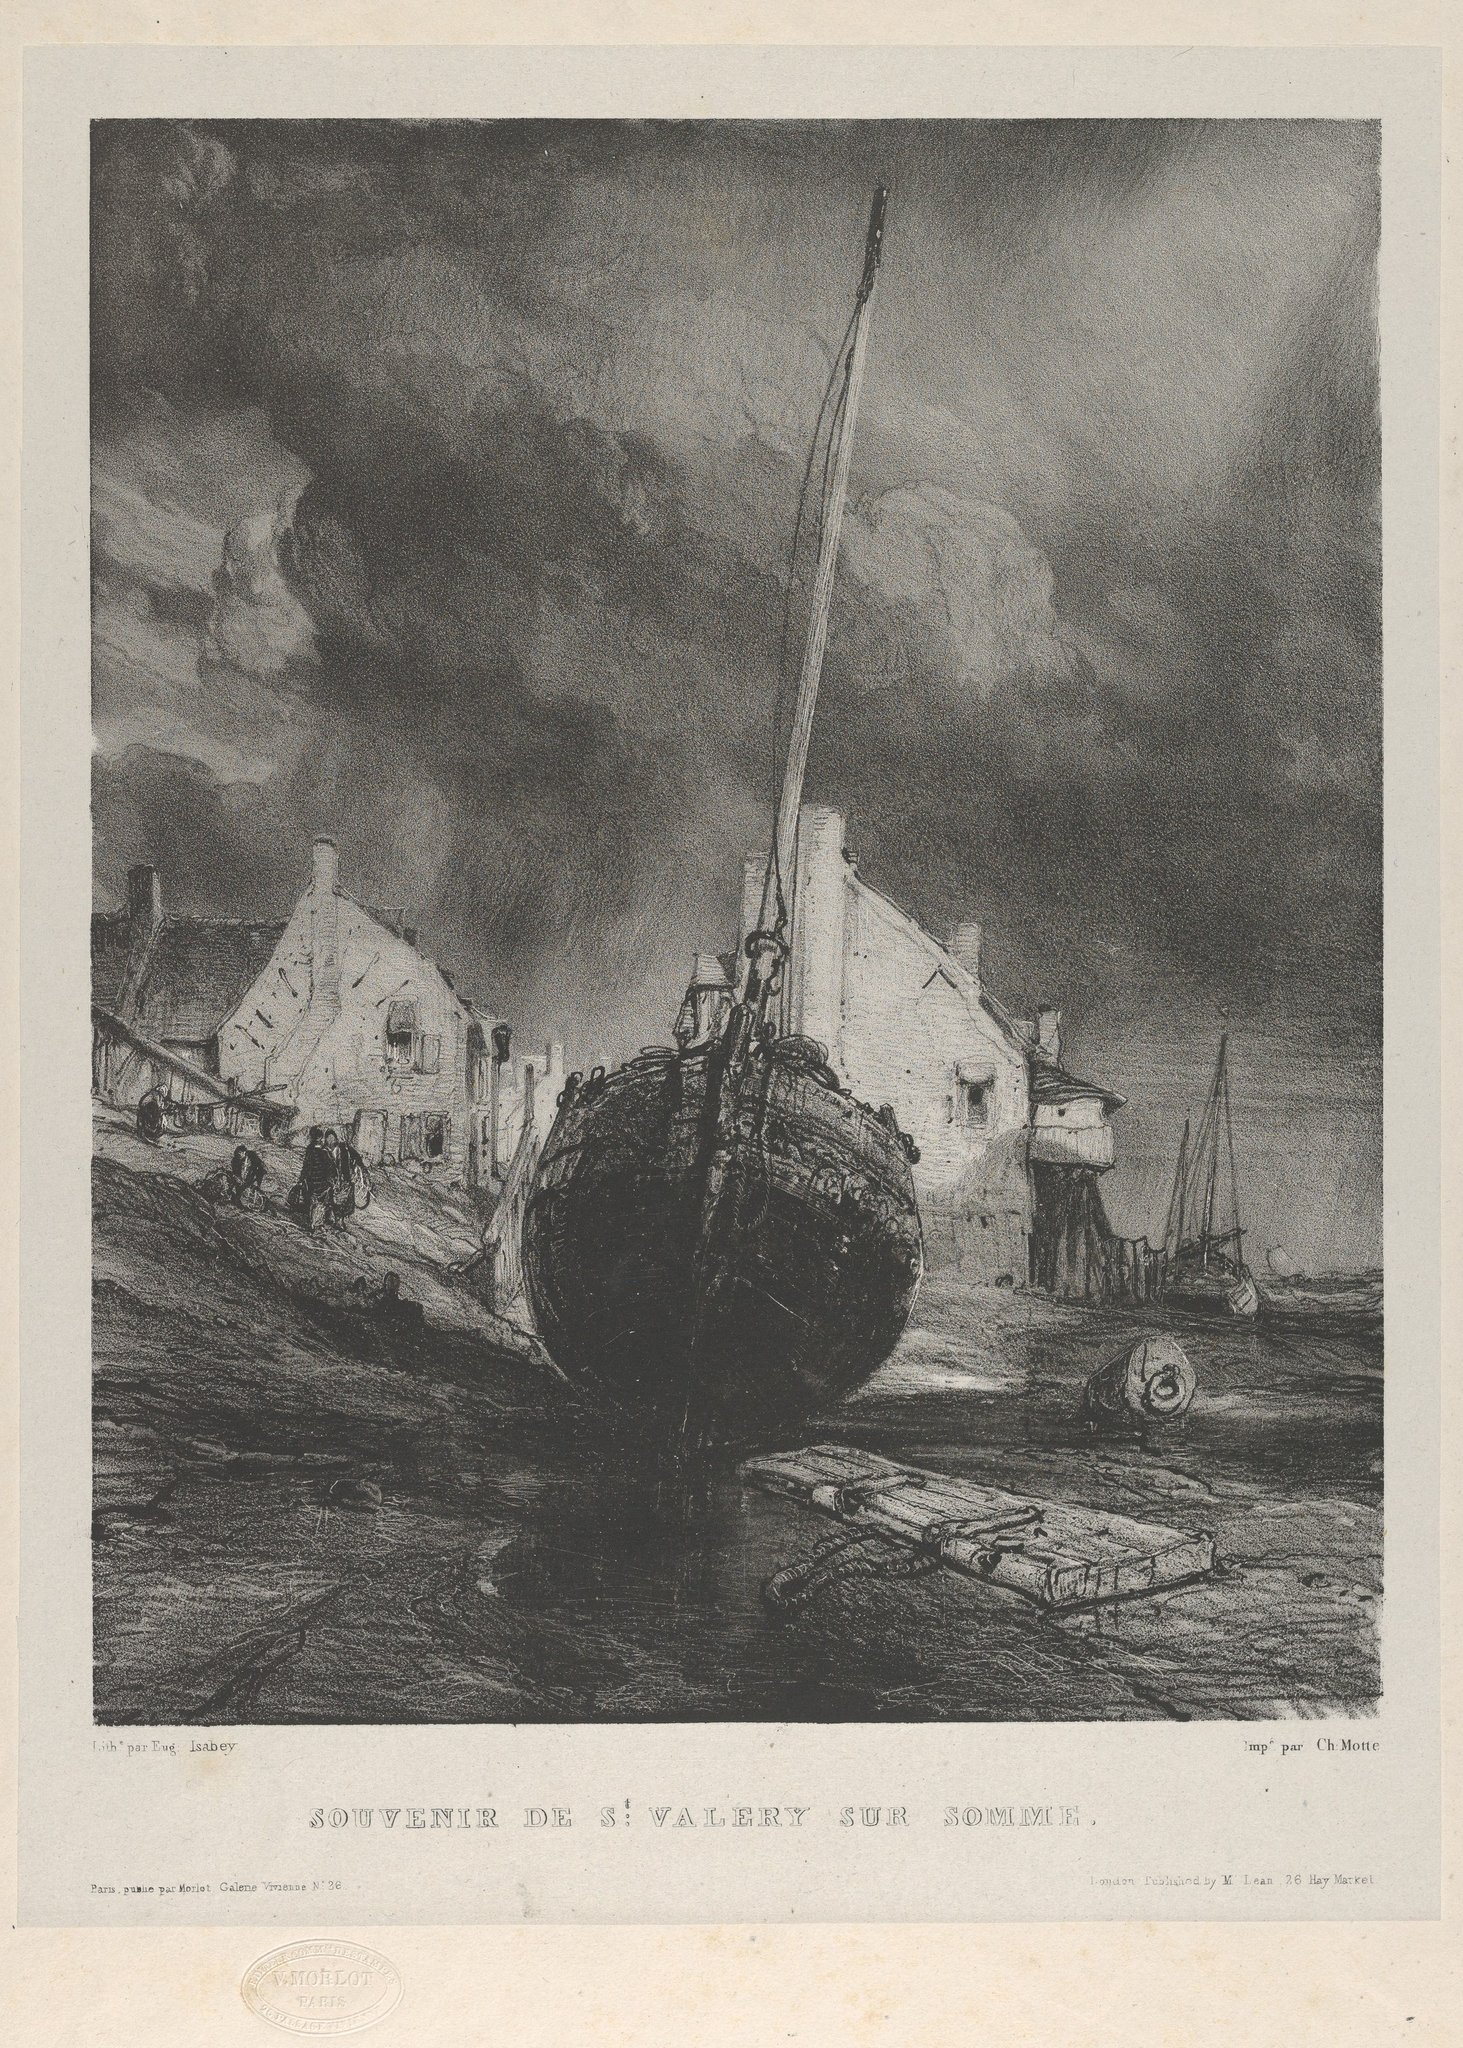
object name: print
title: Memory of Saint-Valéry-sur-Somme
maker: eugène isabey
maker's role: artist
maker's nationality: french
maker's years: 1803-1886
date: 1833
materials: paper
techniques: printmaking, lithograph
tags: ships